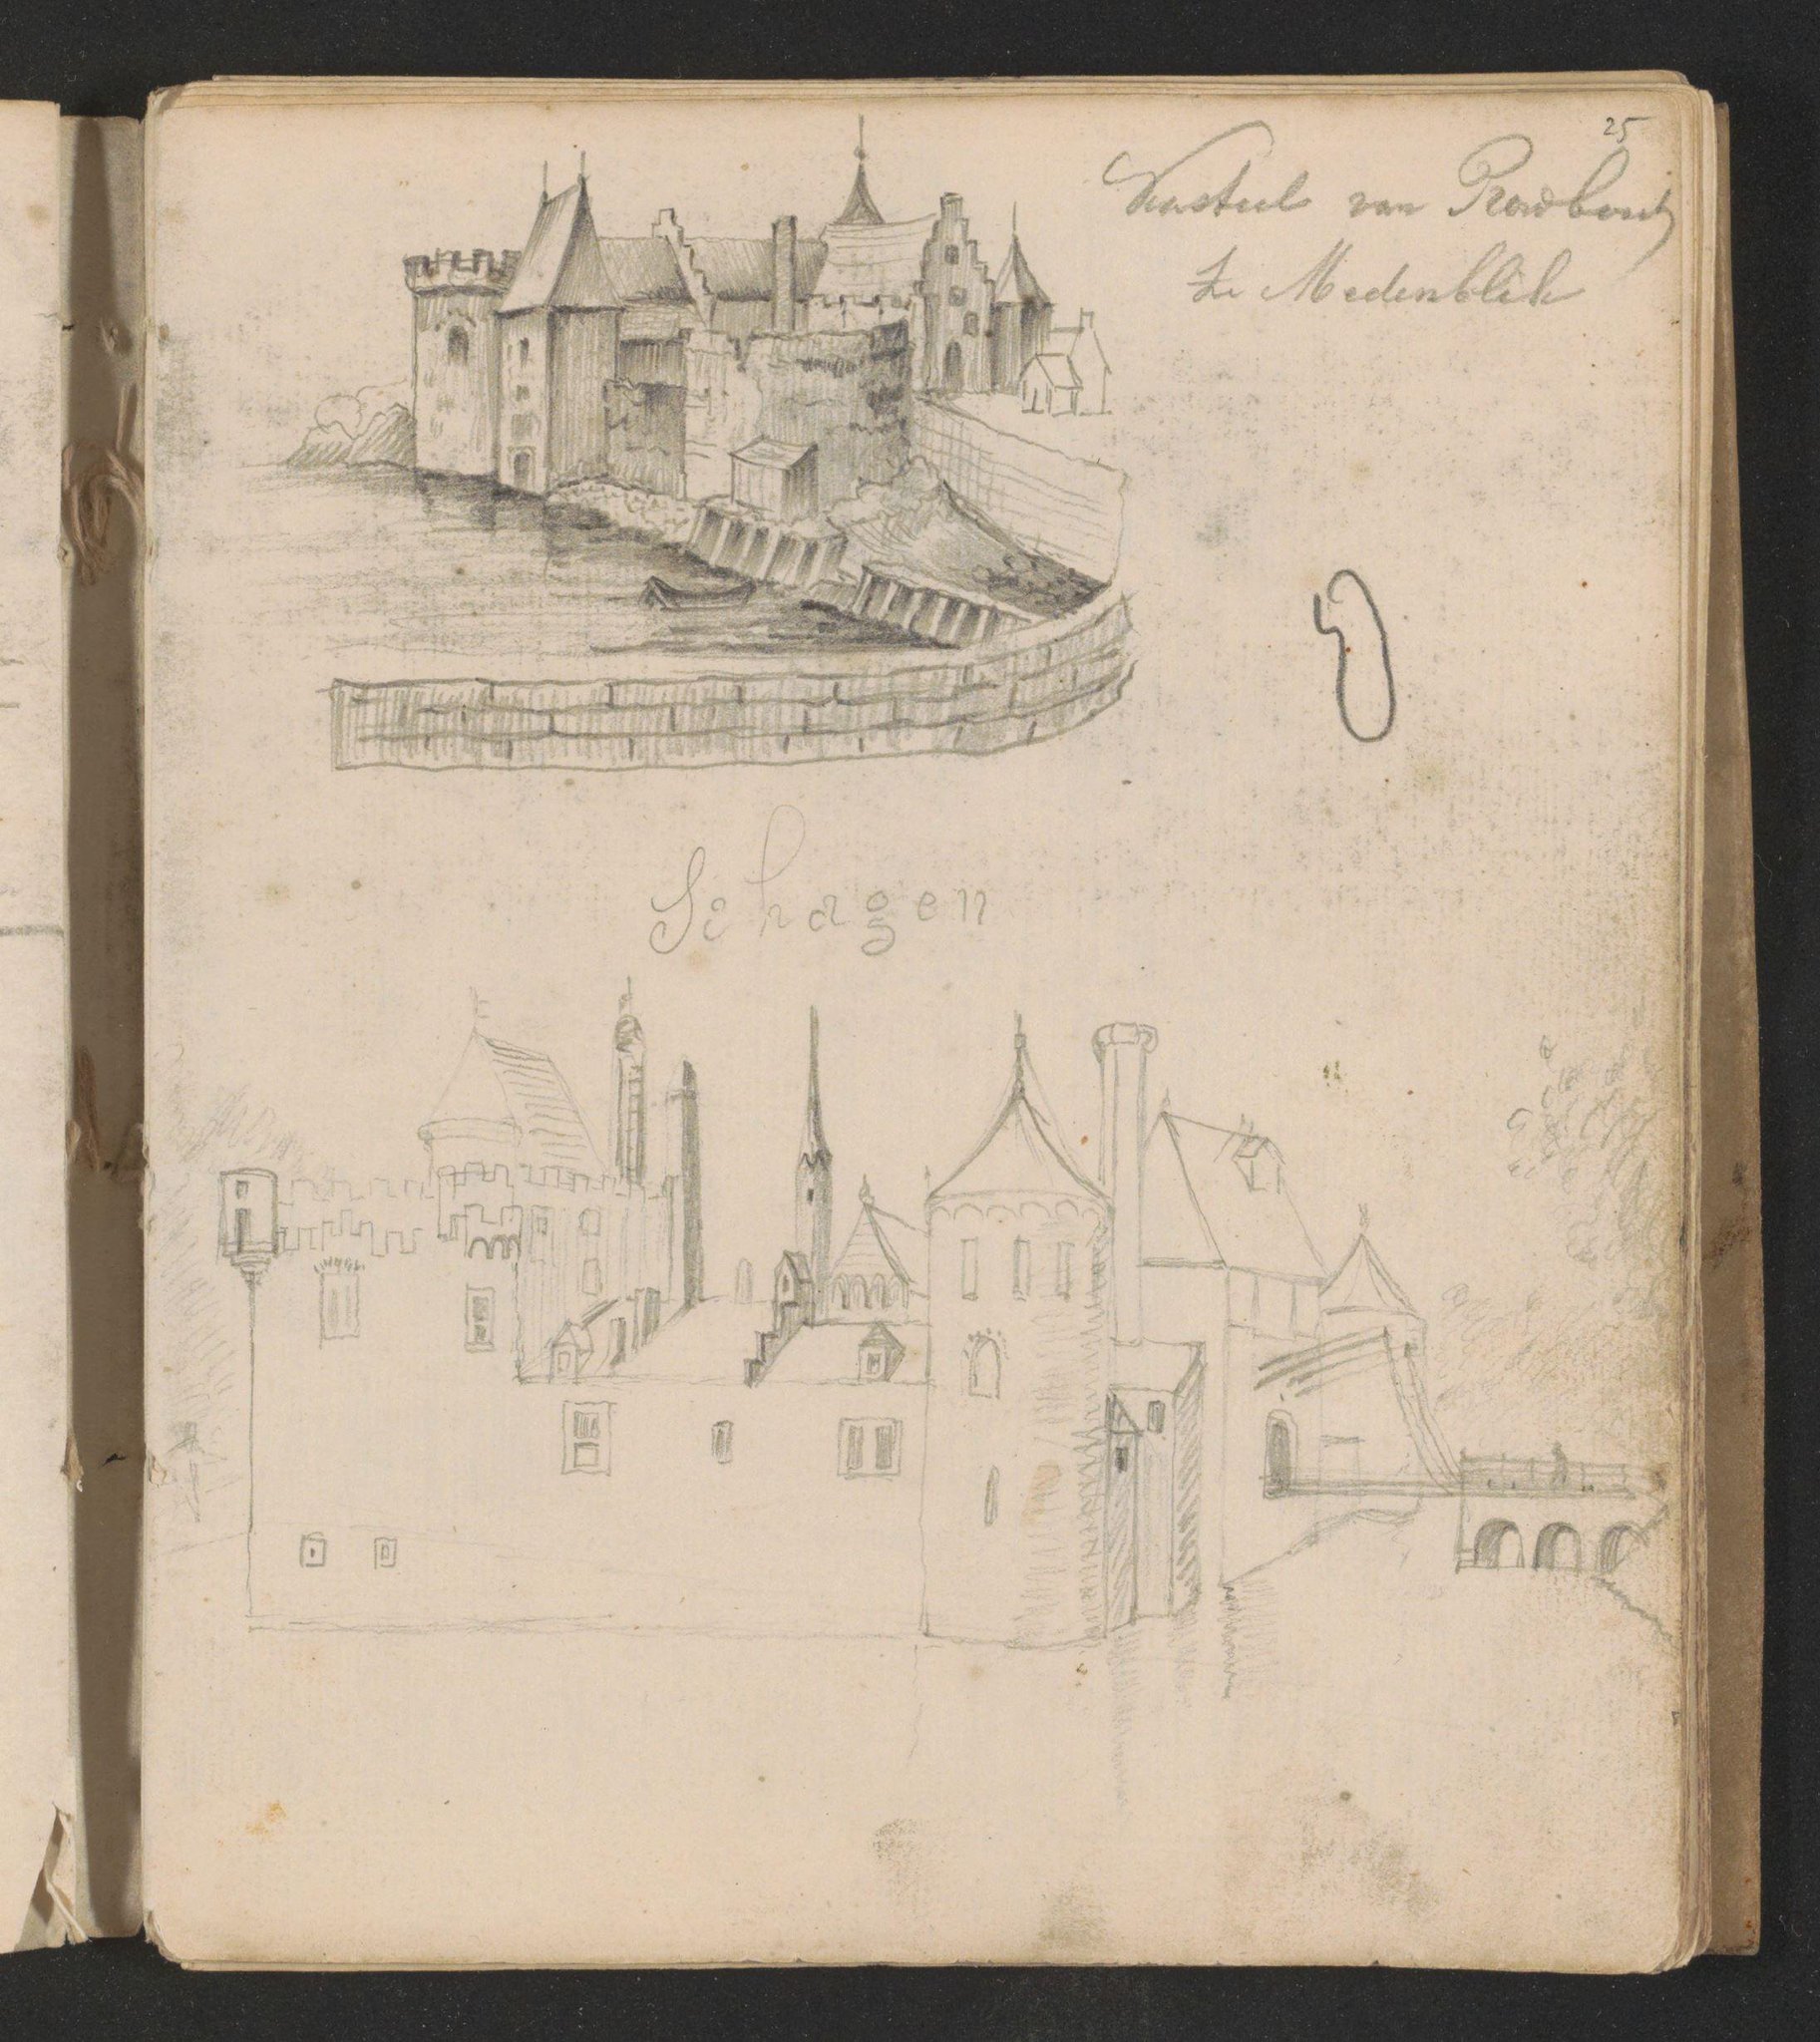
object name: sketchbook leaf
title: Kasteel Radboud te Medemblik en Kasteel Schagen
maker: Anonymous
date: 1840-1860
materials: paper, pencil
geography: schagen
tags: landscape with tower or castle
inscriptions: annotation: ‘Kasteel van Radboud/ te Medemblik/ Schagen’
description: Bladzijde 25 uit een schetsboek met 96 bladzijden.